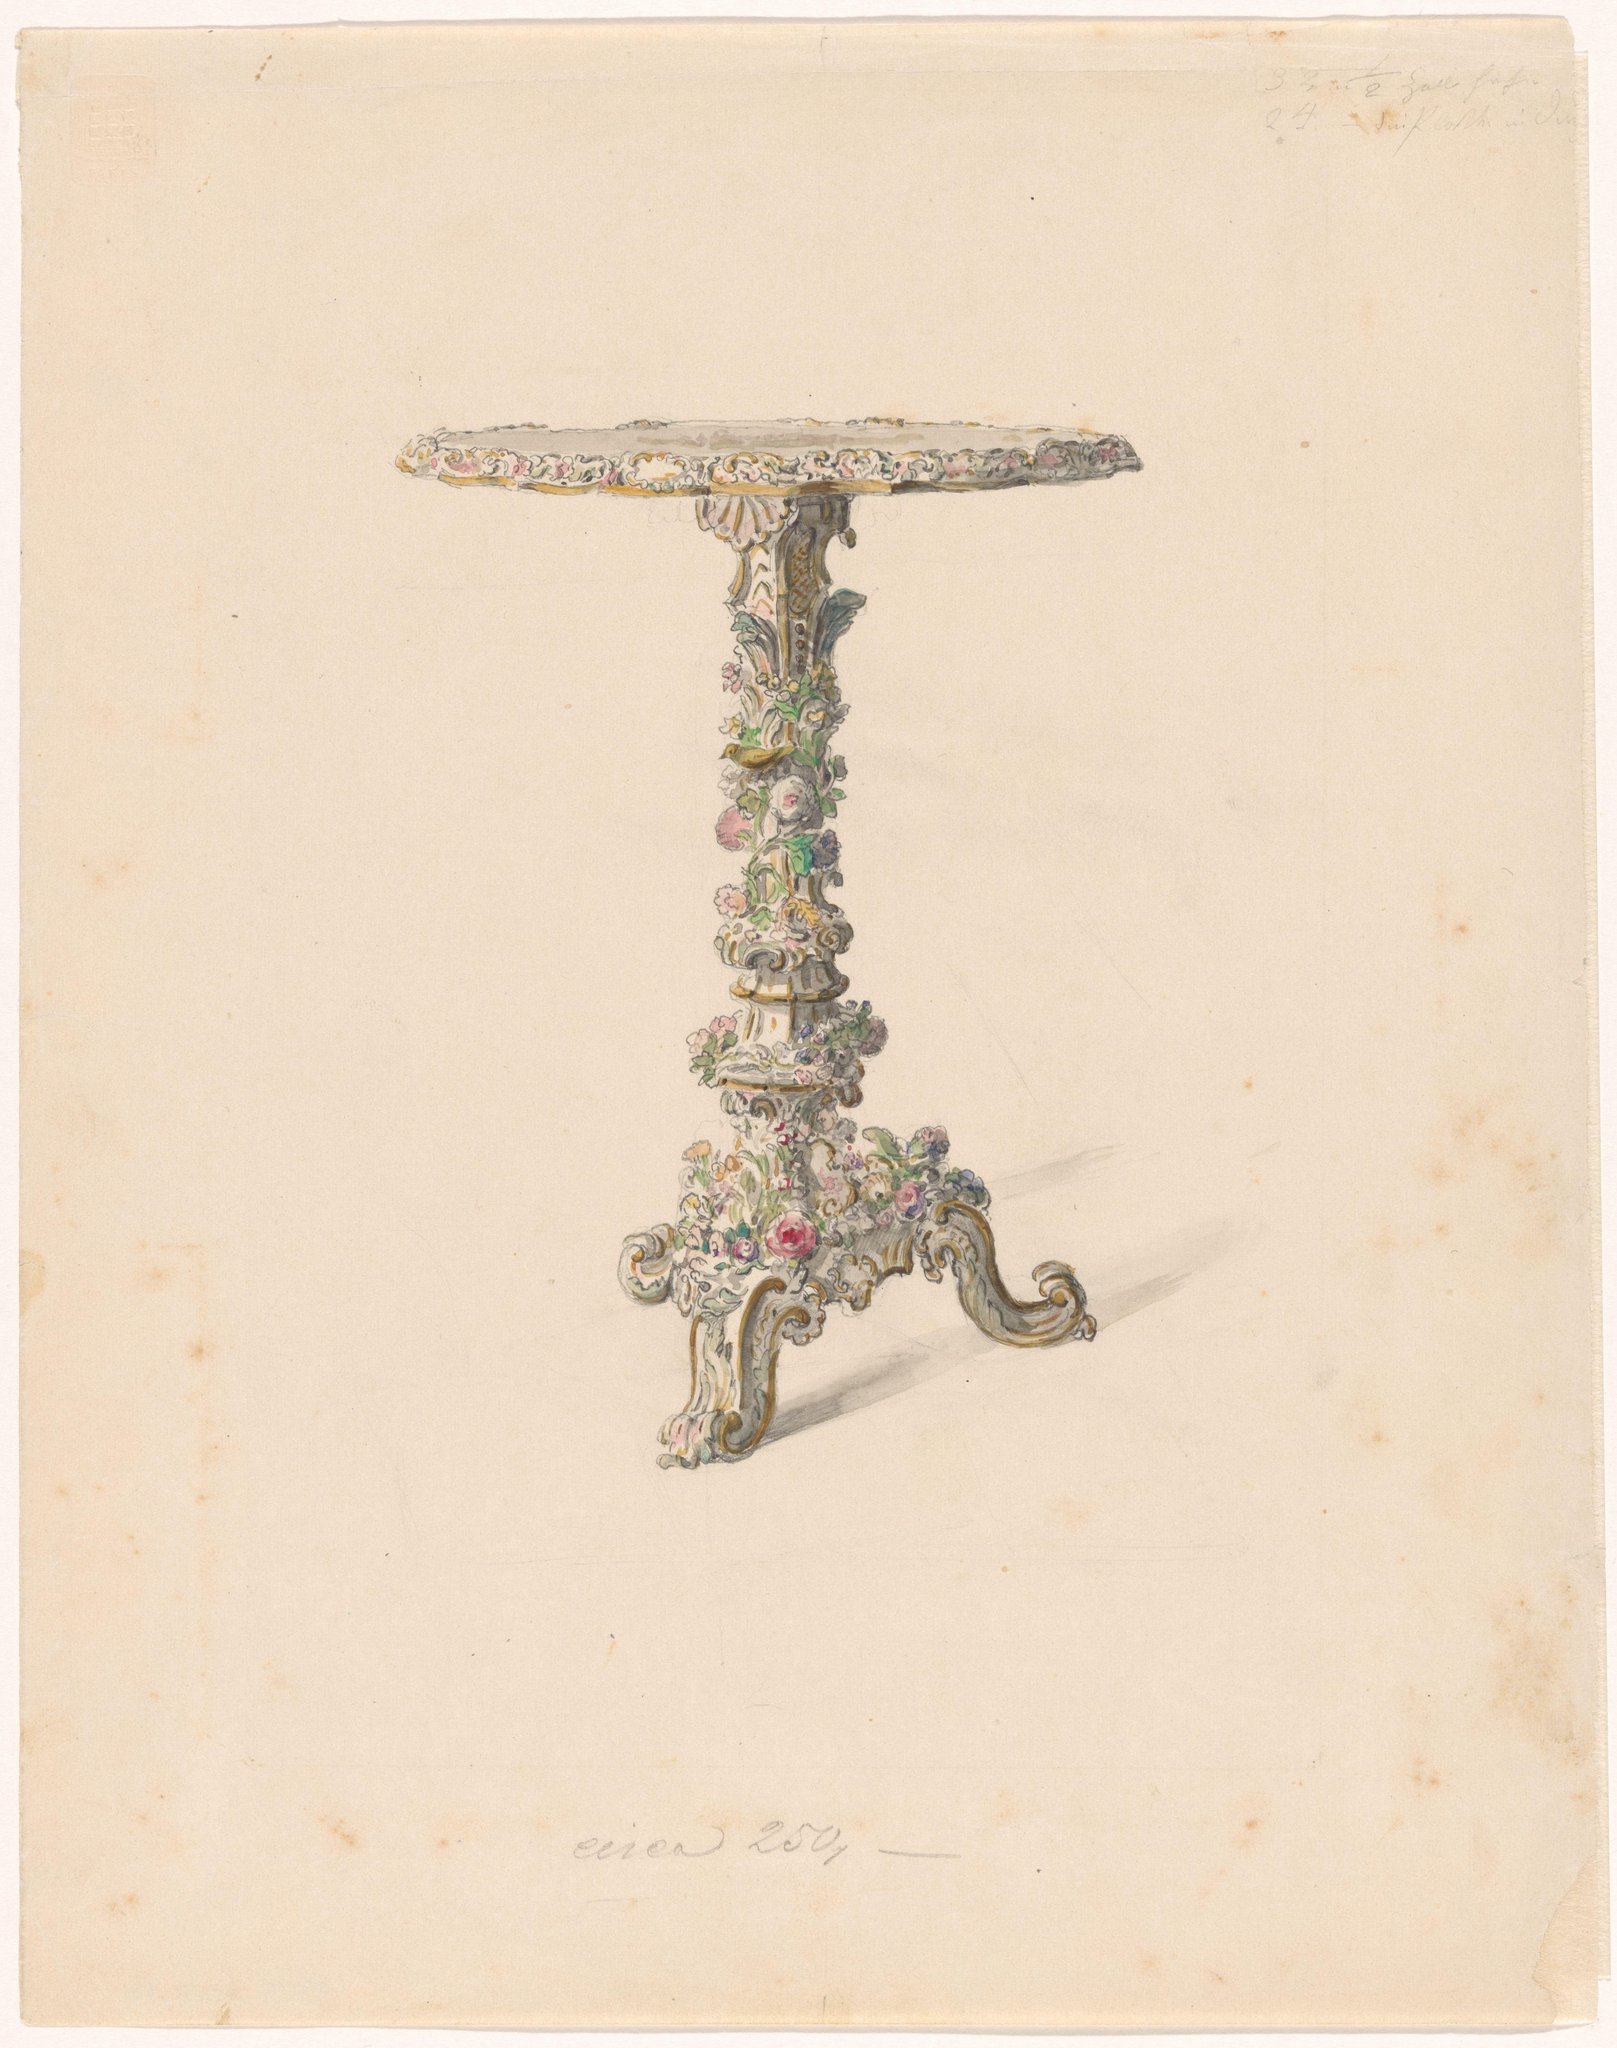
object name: design drawing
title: Ontwerp voor een ronde porseleinen tafel op een voet met bloemen en een vogel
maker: Anonymous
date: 1850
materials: graphite, paper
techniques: pen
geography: germany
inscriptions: inscription: ‘32 ½ […] 24 […]’, inscription: ‘circa 250,-’, check stamp: ‘PARIS’